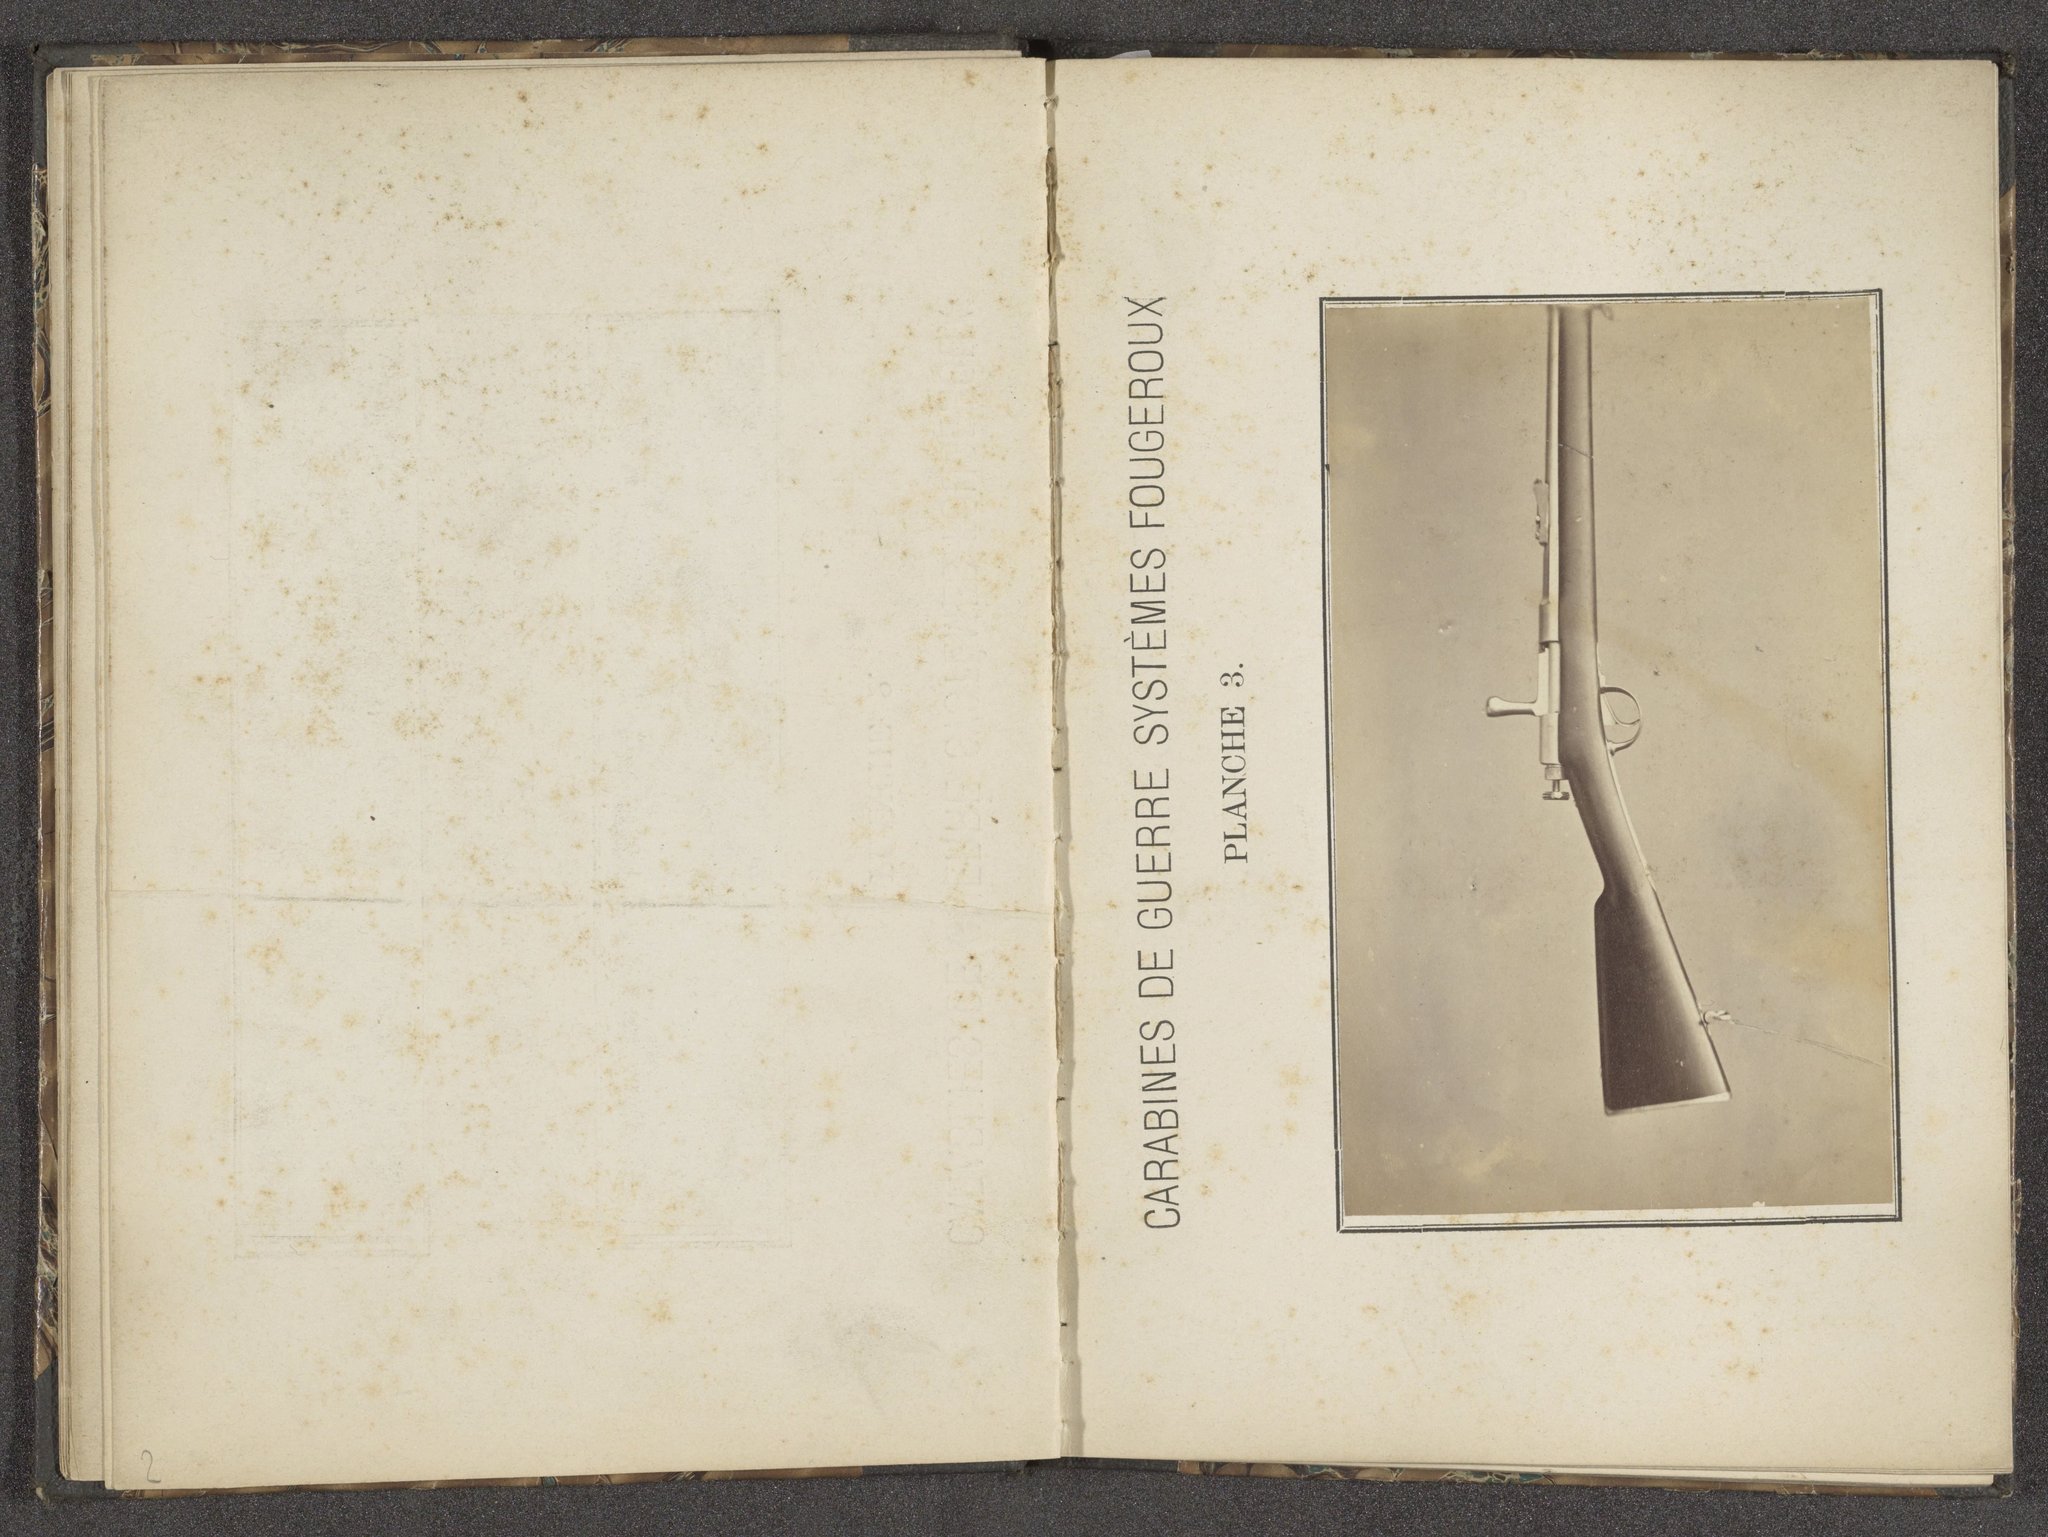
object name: photograph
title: Kolf van een geweer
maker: edouard magis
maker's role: fotograaf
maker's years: 1828-1906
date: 1857-1867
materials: photographic support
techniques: albumen print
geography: liège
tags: firearms: rifle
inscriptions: number: ‘Planche 3.’, inscription: ‘Carabines de guerres systèmes Fougeroux’